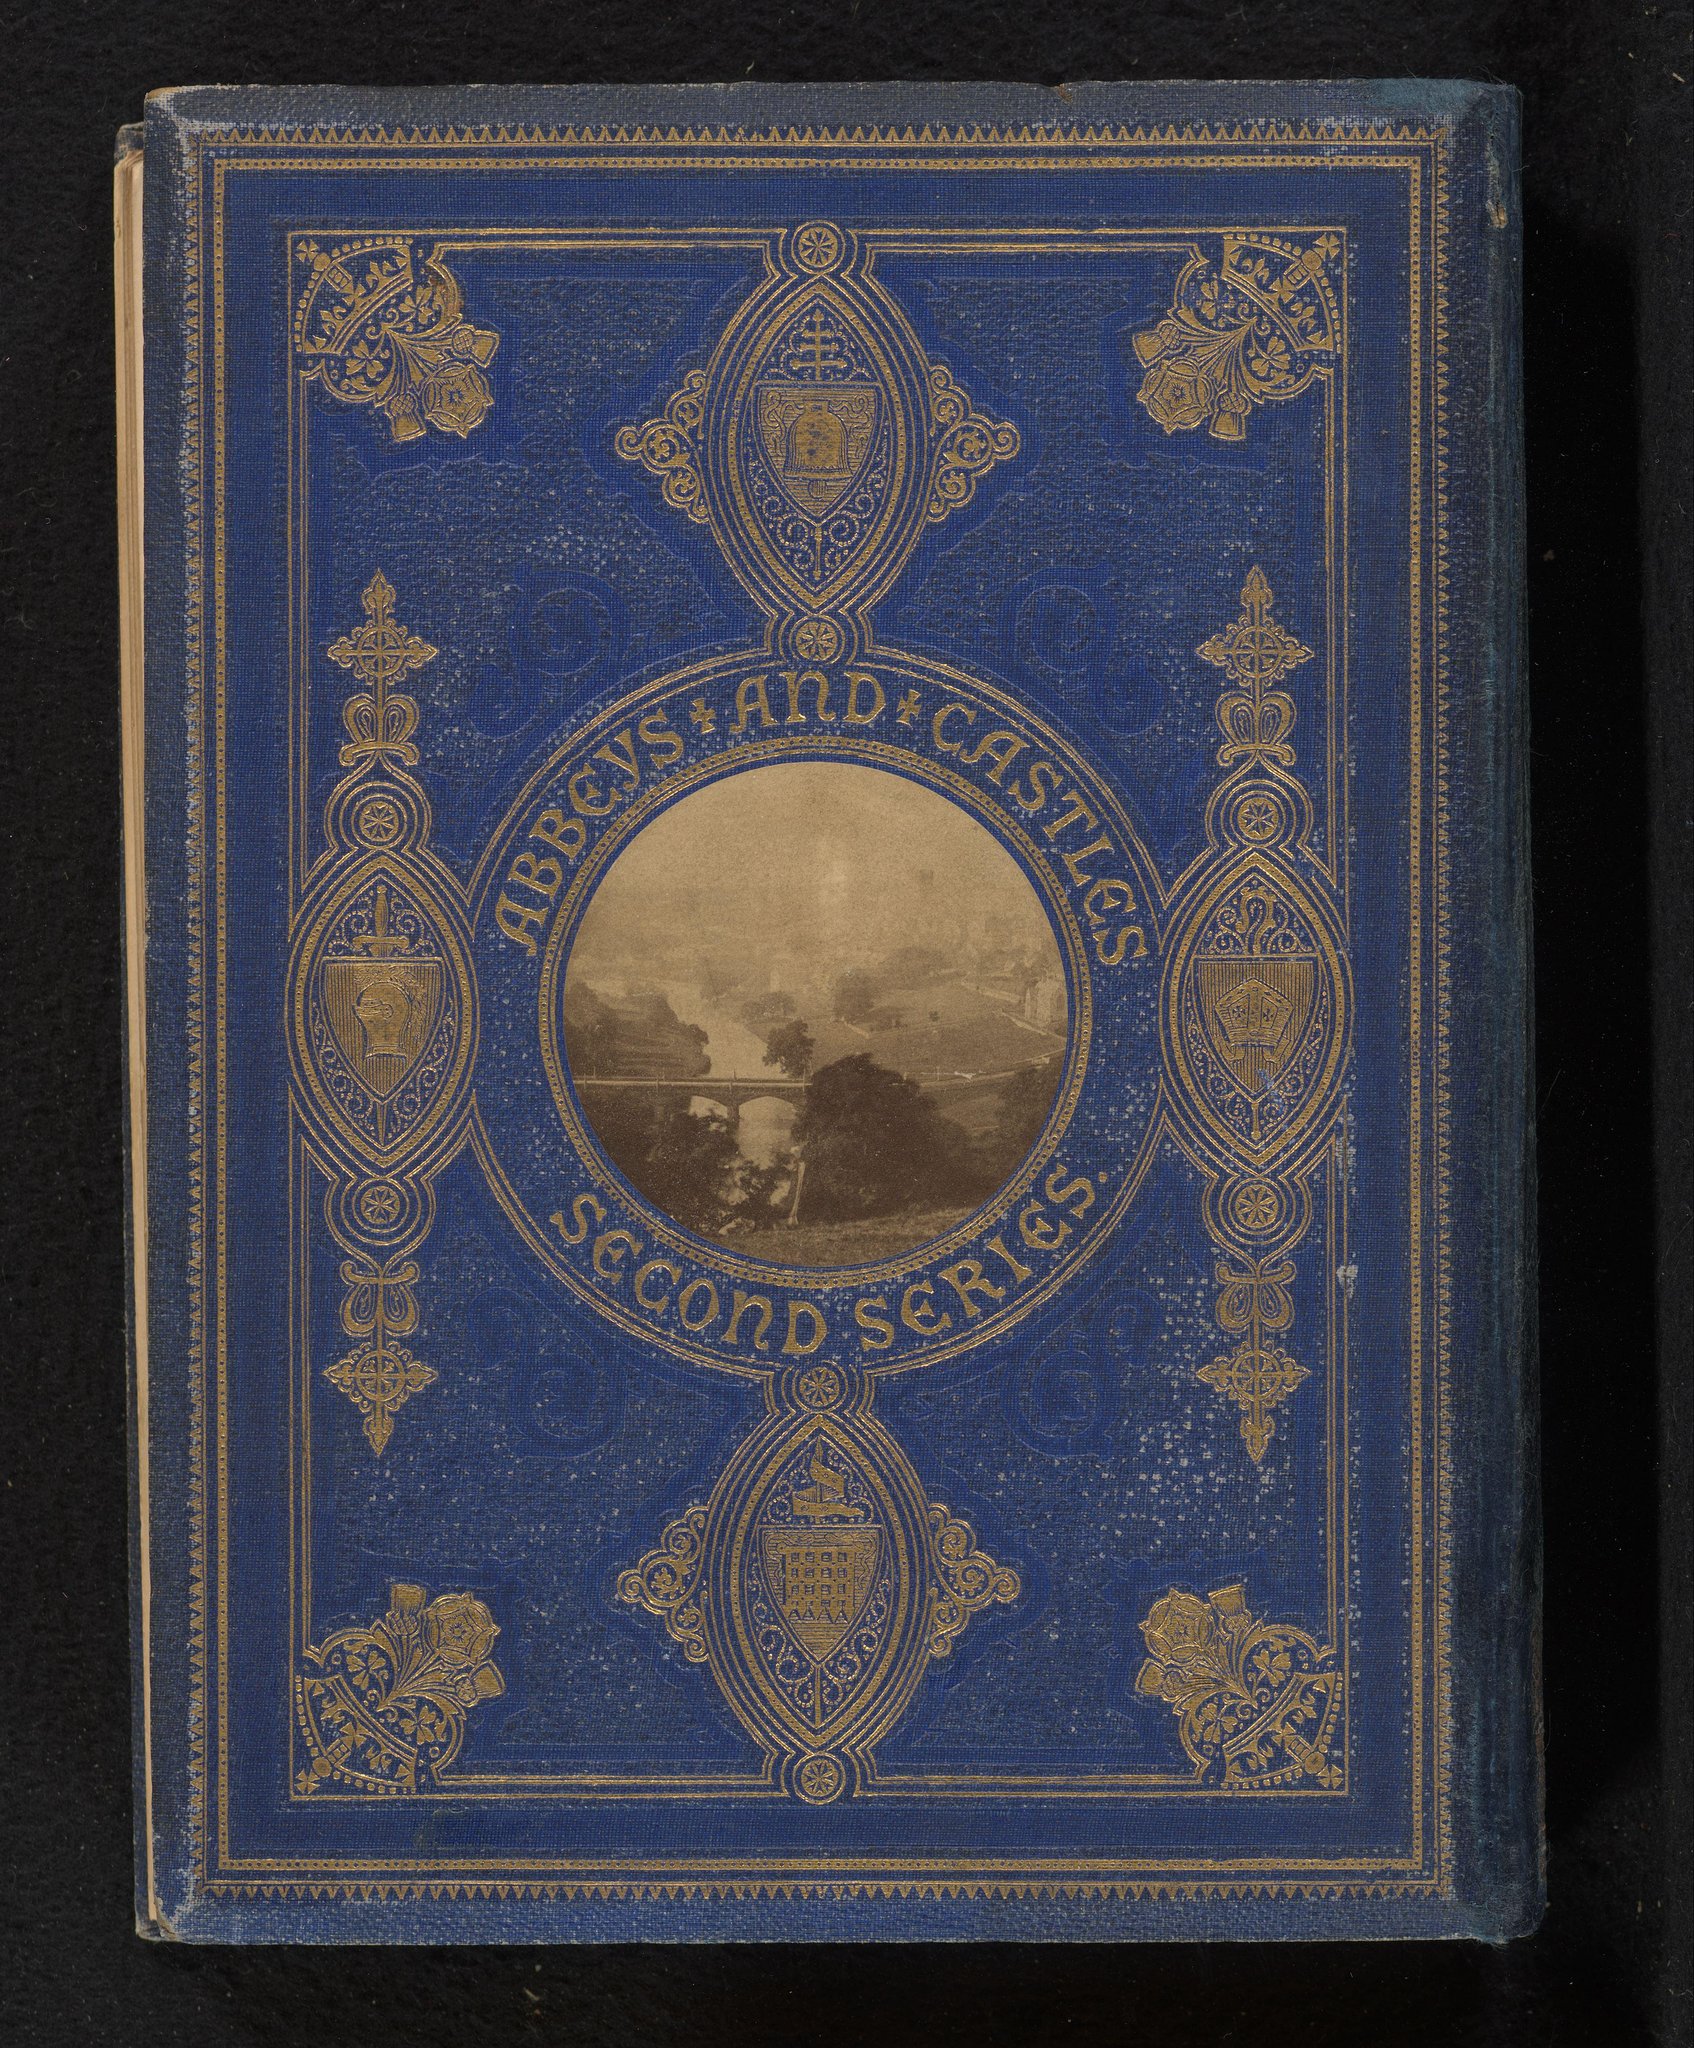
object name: photograph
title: Landschap met brug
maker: Anonymous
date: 1859-1864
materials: paper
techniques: albumen print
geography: great britain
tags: river, bridge, great britain